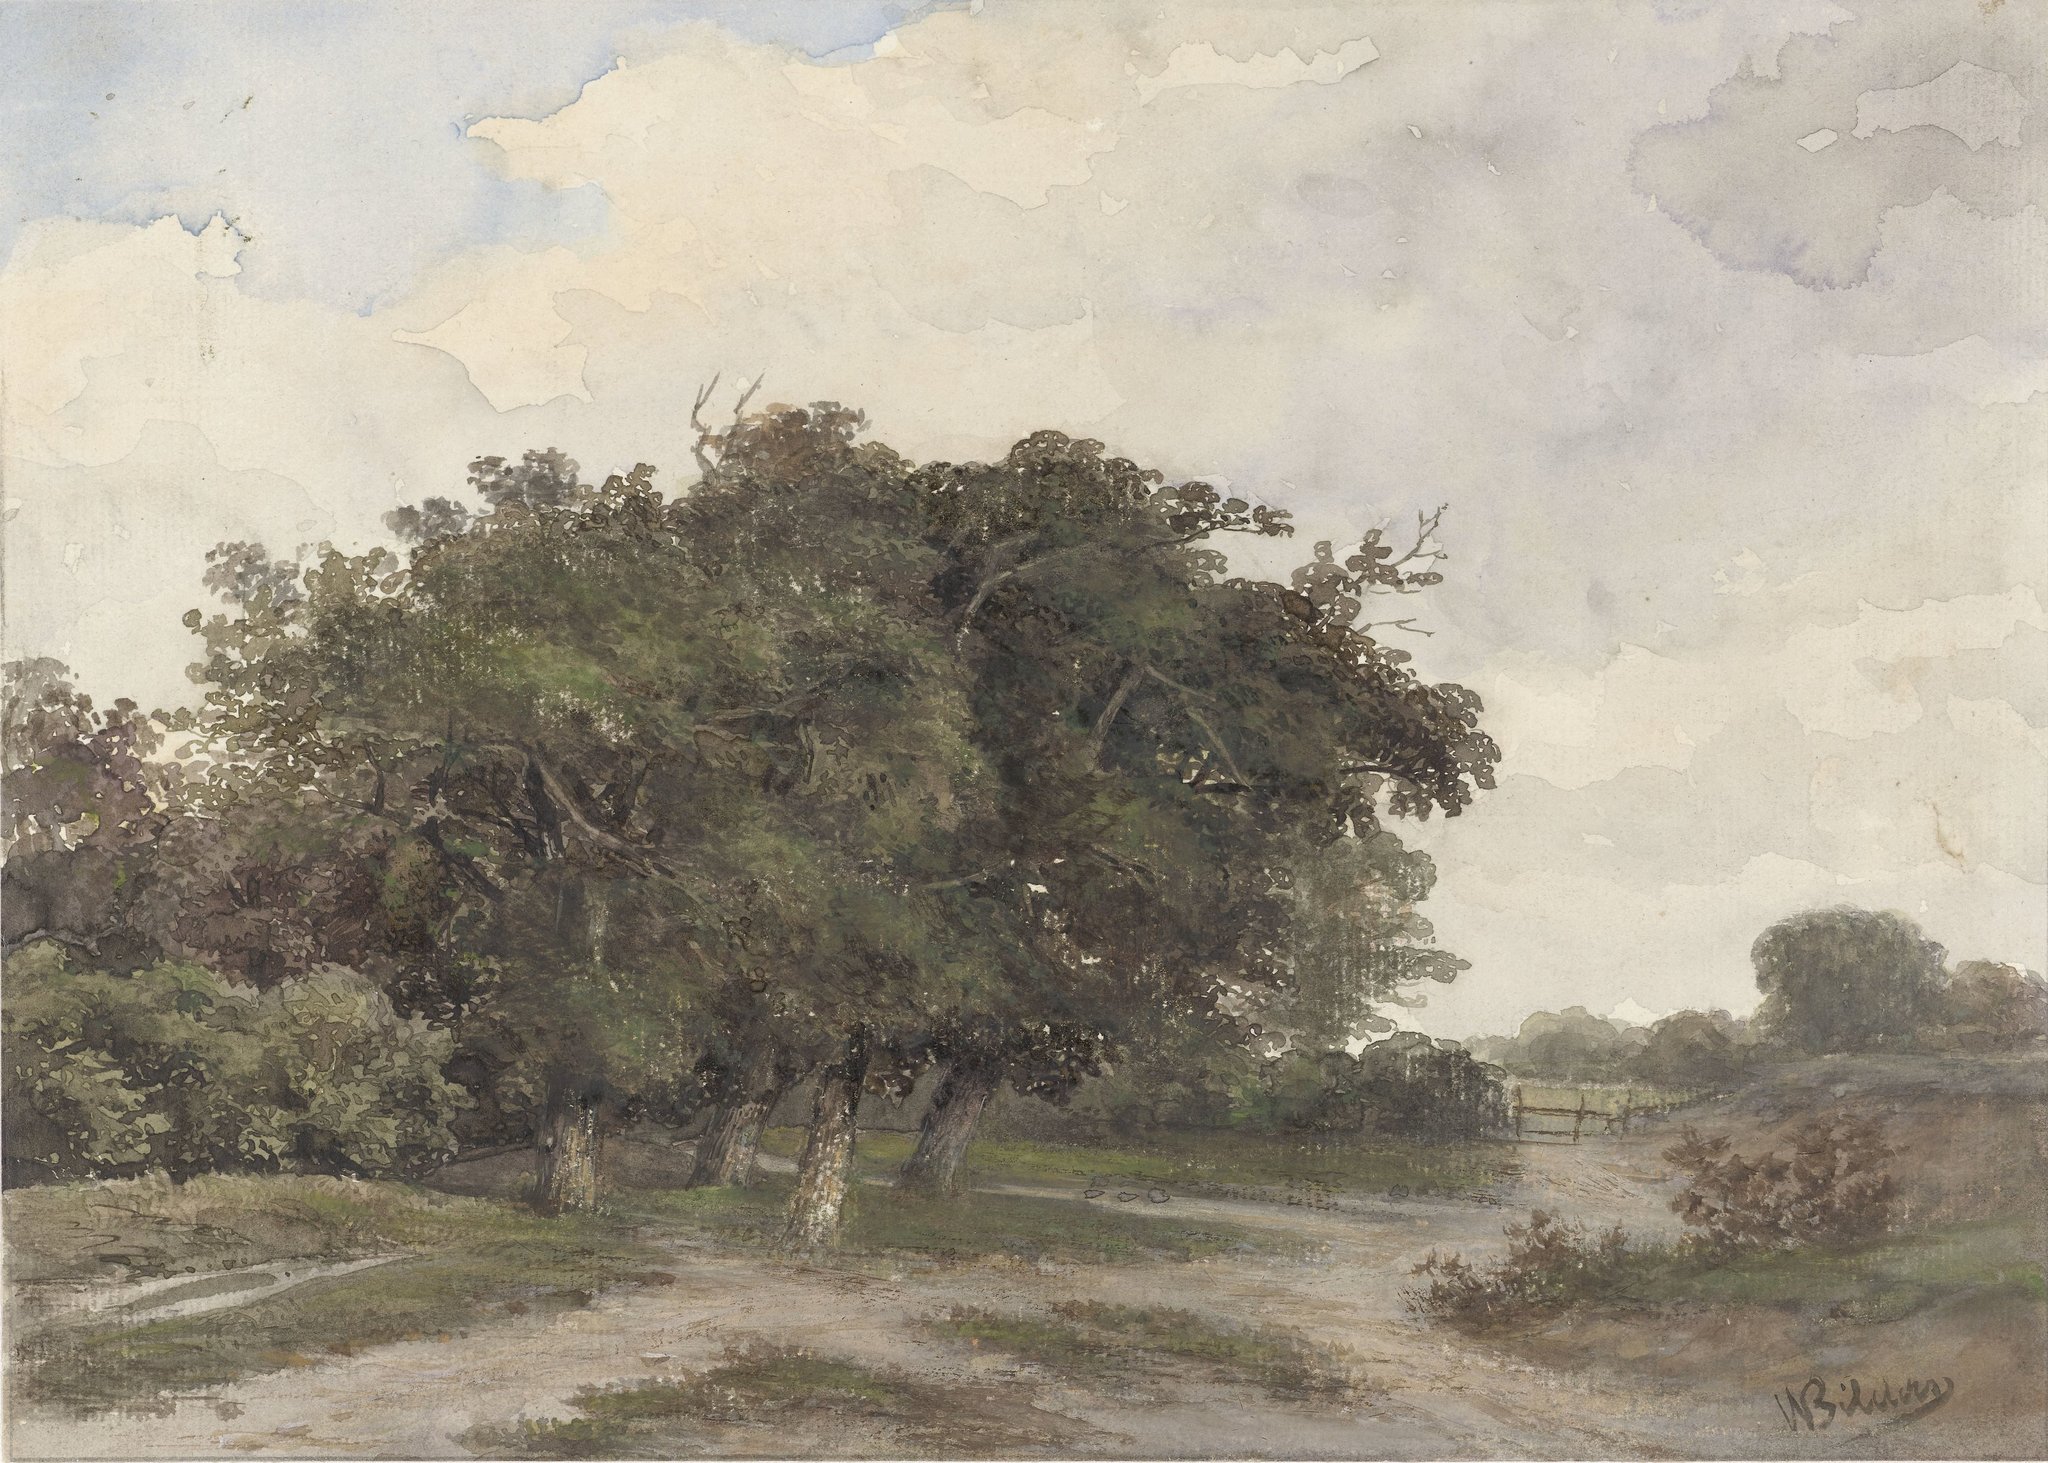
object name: drawing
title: Landschap met bomen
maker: johannes warnardus bilders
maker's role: painter, print maker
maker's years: 1811-1890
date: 1841-1890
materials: paper, watercolor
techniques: brush